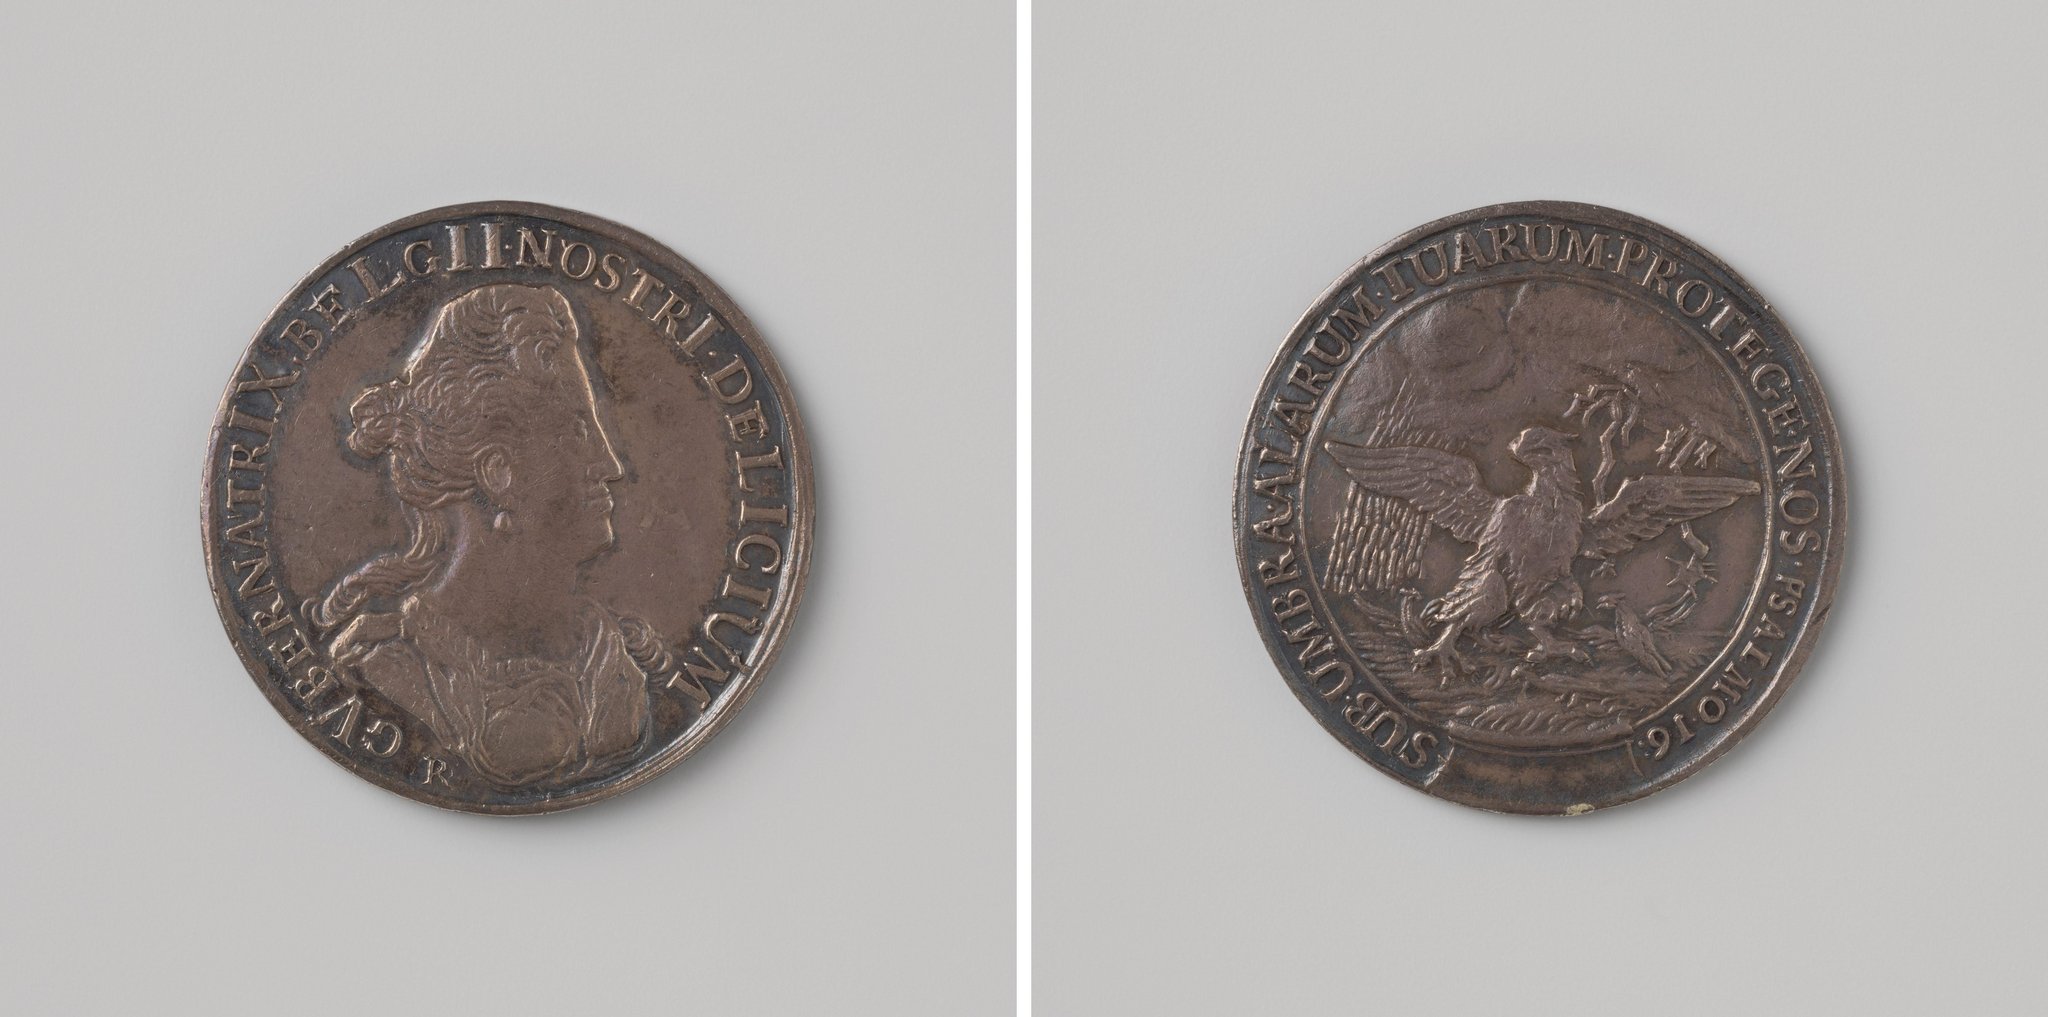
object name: new year medal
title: Maria Elisabeth van Oostenrijk, ingehuldigd als landvoogdes der zuidelijke Nederlanden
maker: philippe roëttiers (iii)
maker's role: medailleur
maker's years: 1686-1873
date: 1726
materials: silver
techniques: striking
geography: brussels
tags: maria elisabeth (aartshertogin van oostenrijk)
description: Zilveren penning. Voorzijde: borststuk vrouw binnen omschrift. Keerzijde: arend beschermt met zijn uitgespreide vleugels zijn jongen, die angstig beschutting zoeken voor regen en bliksem binnen omschrift